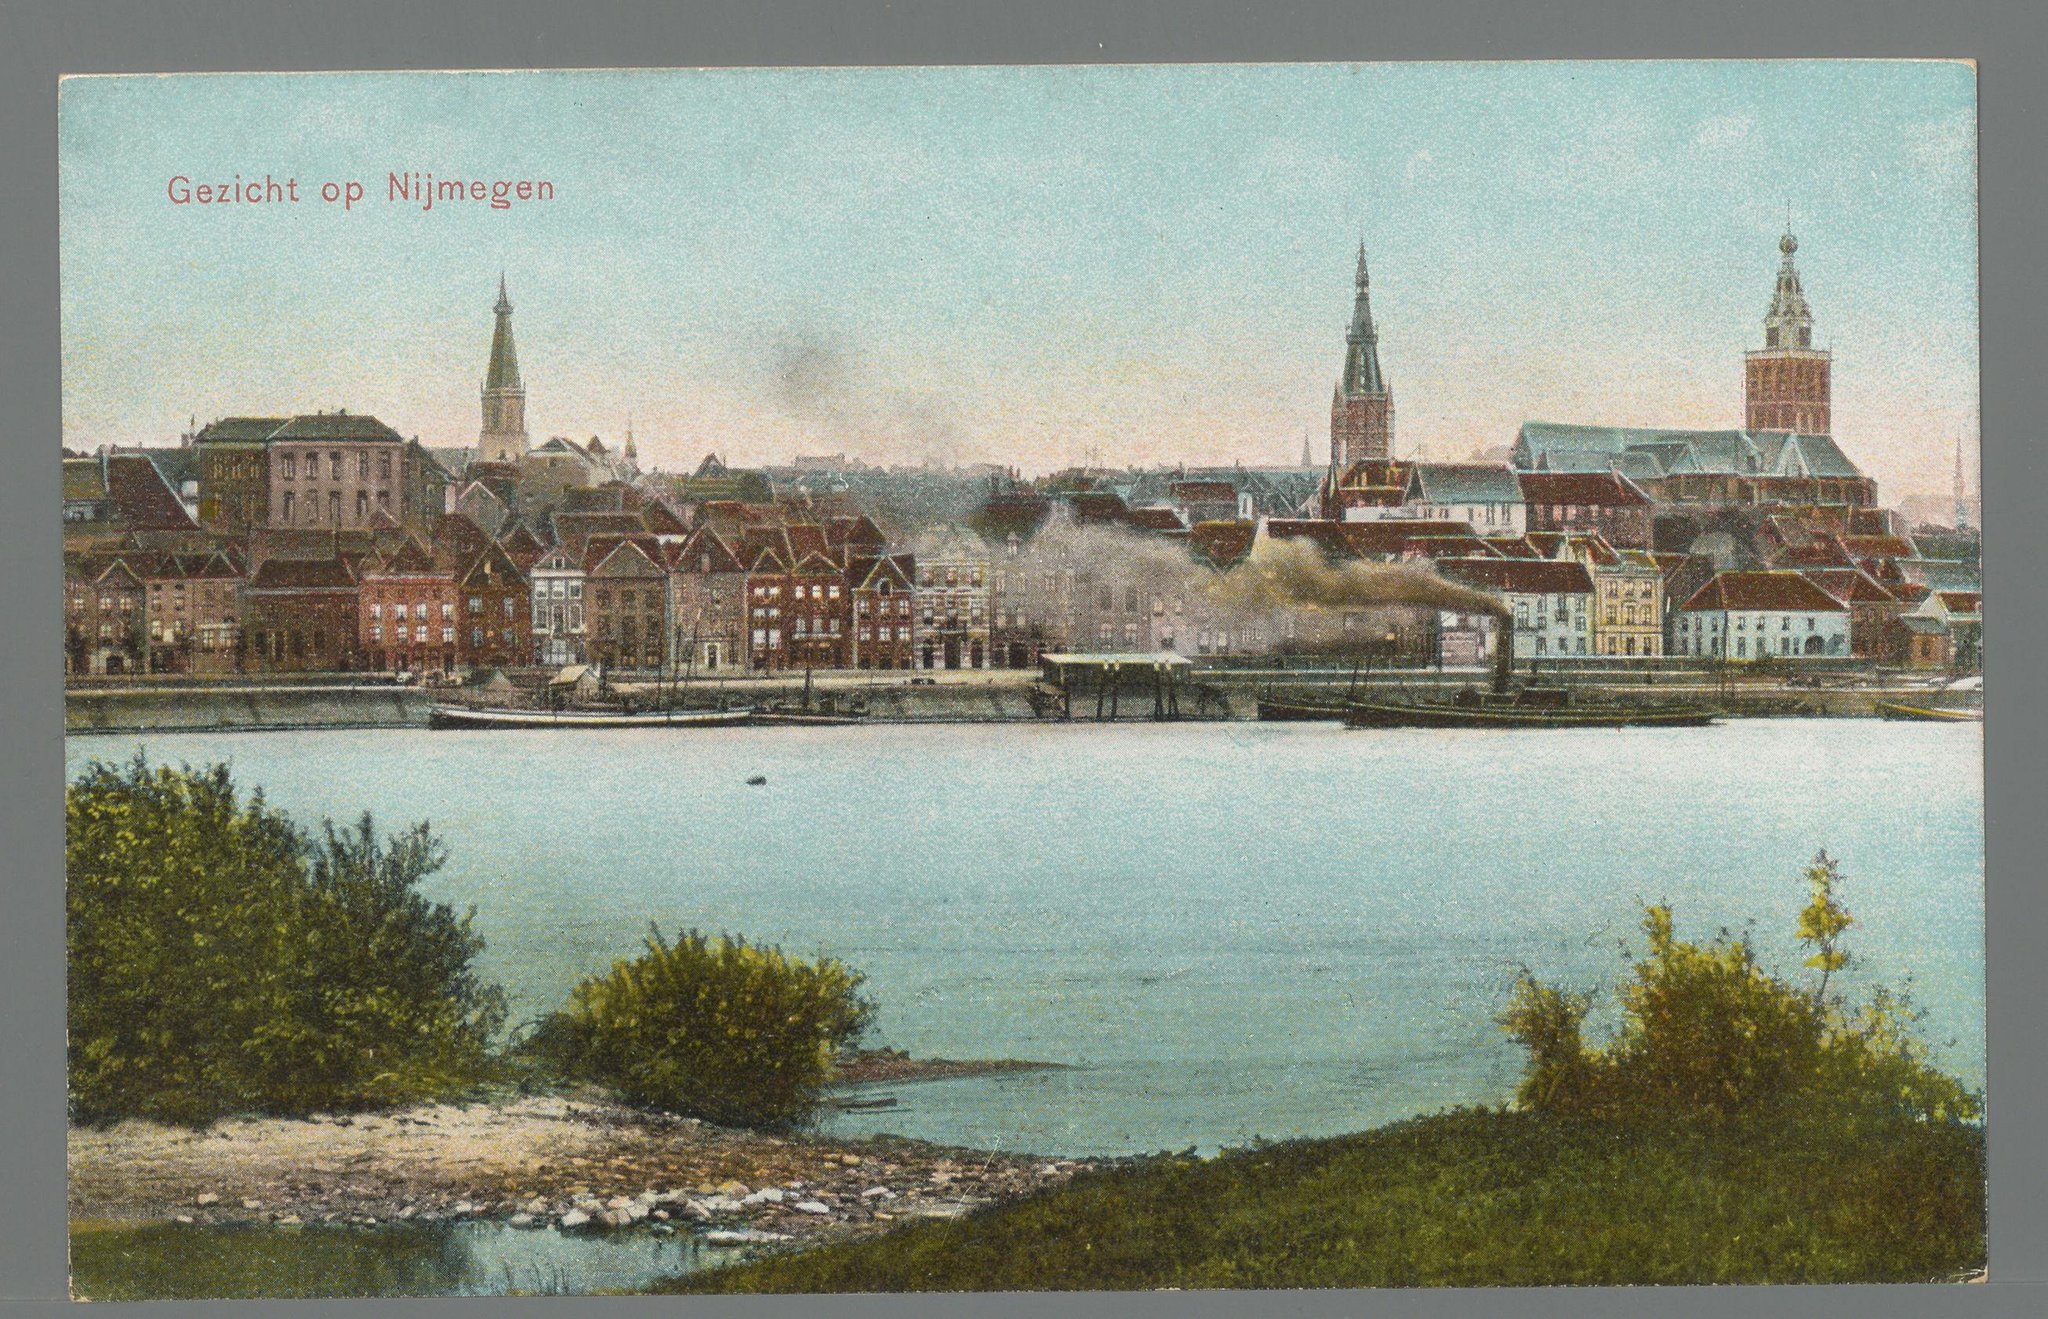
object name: photomechanical print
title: Gezicht op Nijmegen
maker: Anonymous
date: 1908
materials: cardboard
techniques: lithograph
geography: leipzig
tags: river, church (exterior), prospect of city, town panorama, silhouette of city, nijmegen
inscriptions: date